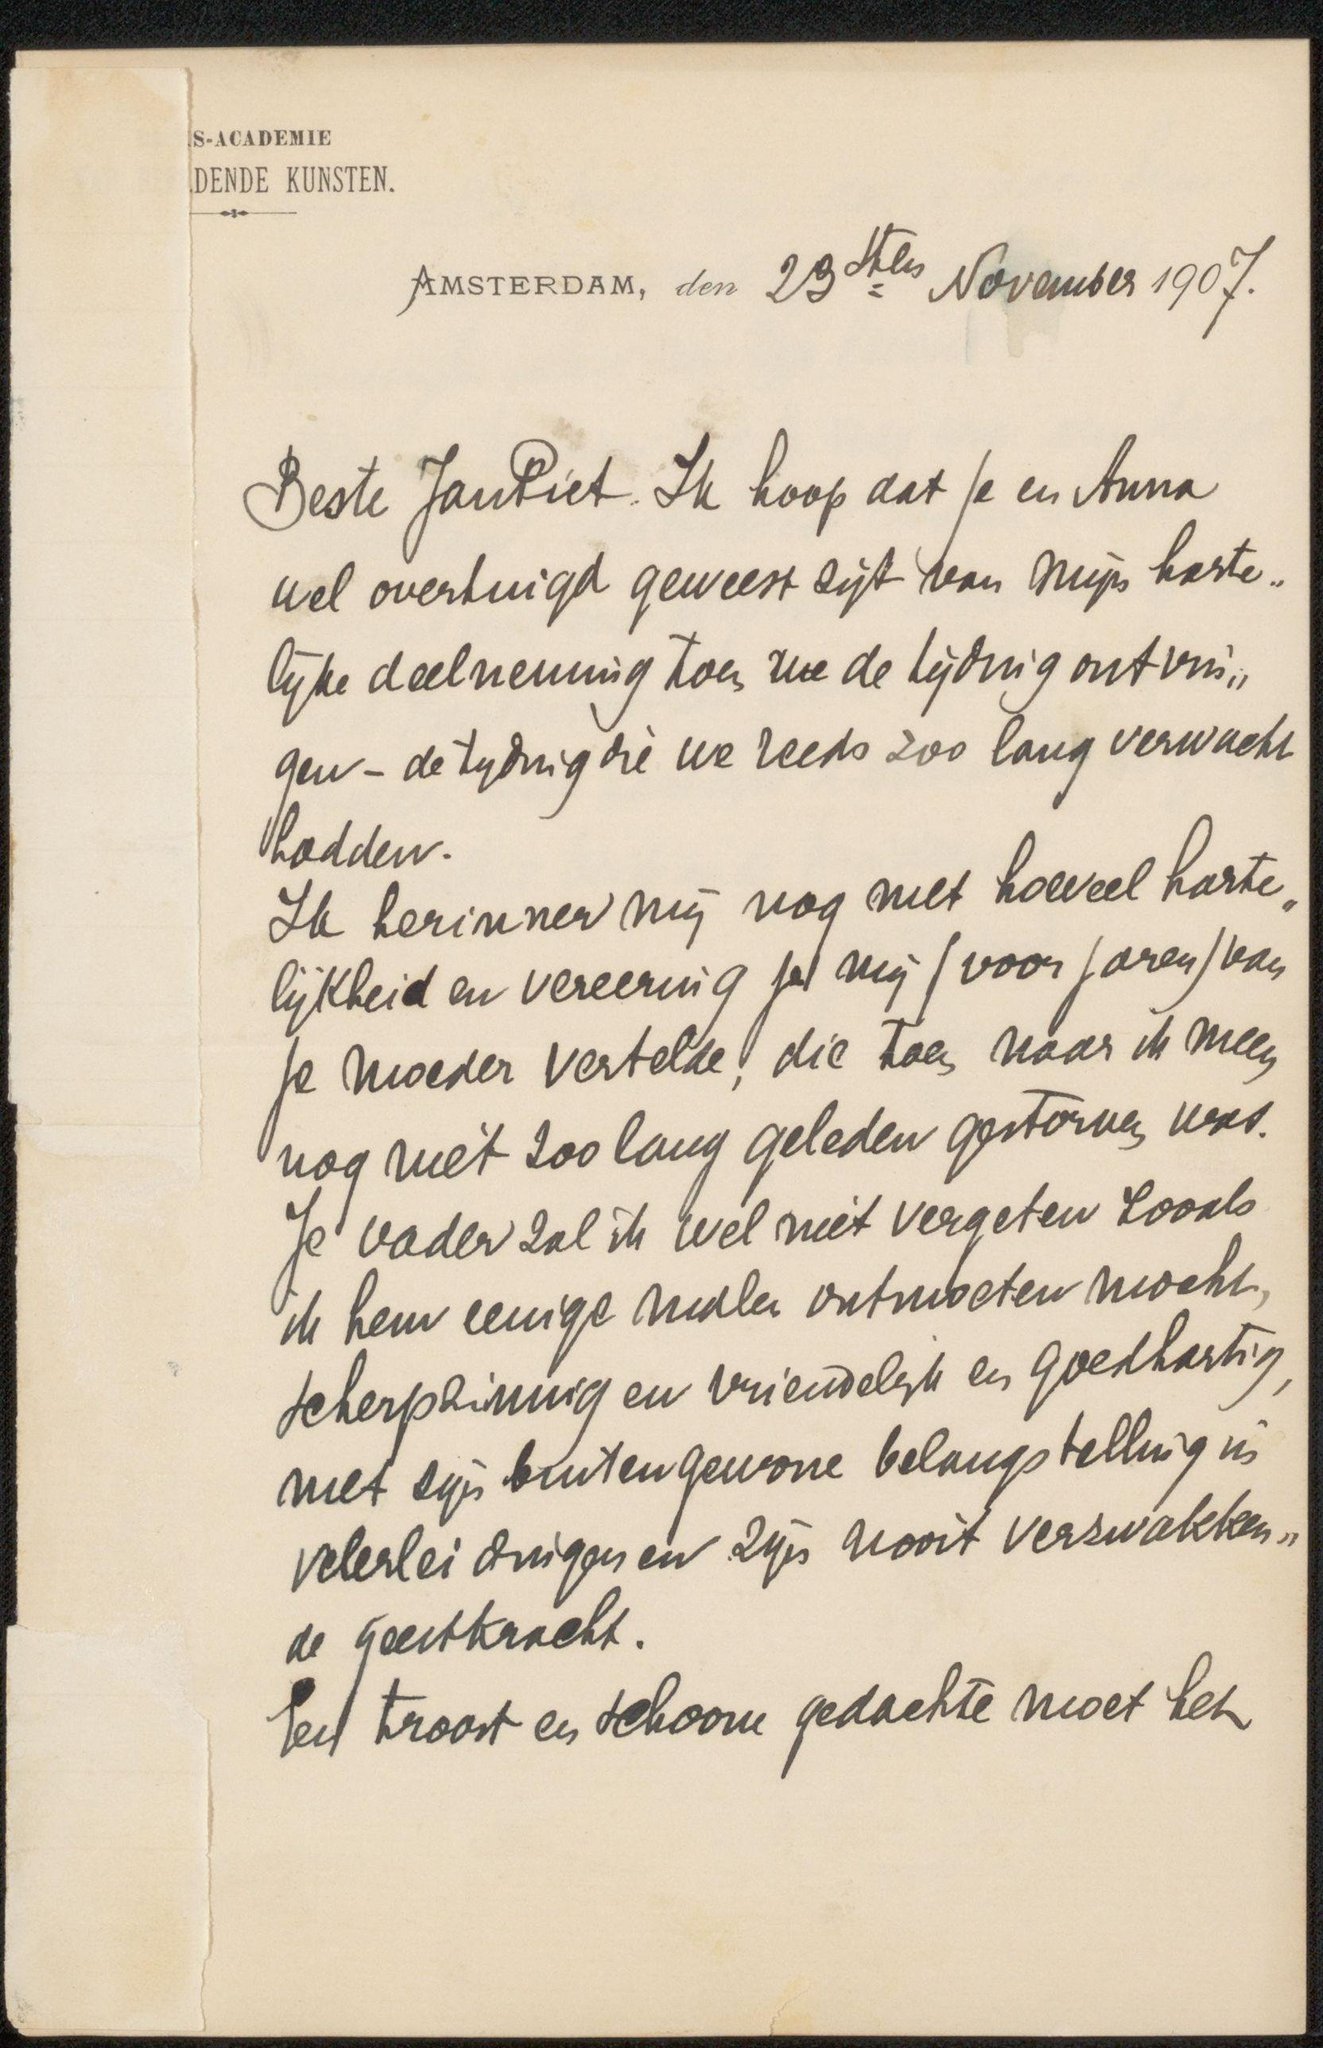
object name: letter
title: Brief aan Jan Veth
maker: antoon derkinderen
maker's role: draughtsman, painter, print maker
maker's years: 1859-1925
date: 1907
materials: ink, paper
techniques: pen, printing, writing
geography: amsterdam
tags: print room, dordrecht, painter, jan veth, utrecht, amsterdam, johanna henriëtte besier, artist, anna dorothea dirks, family life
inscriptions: collector's mark: ‘RPK’